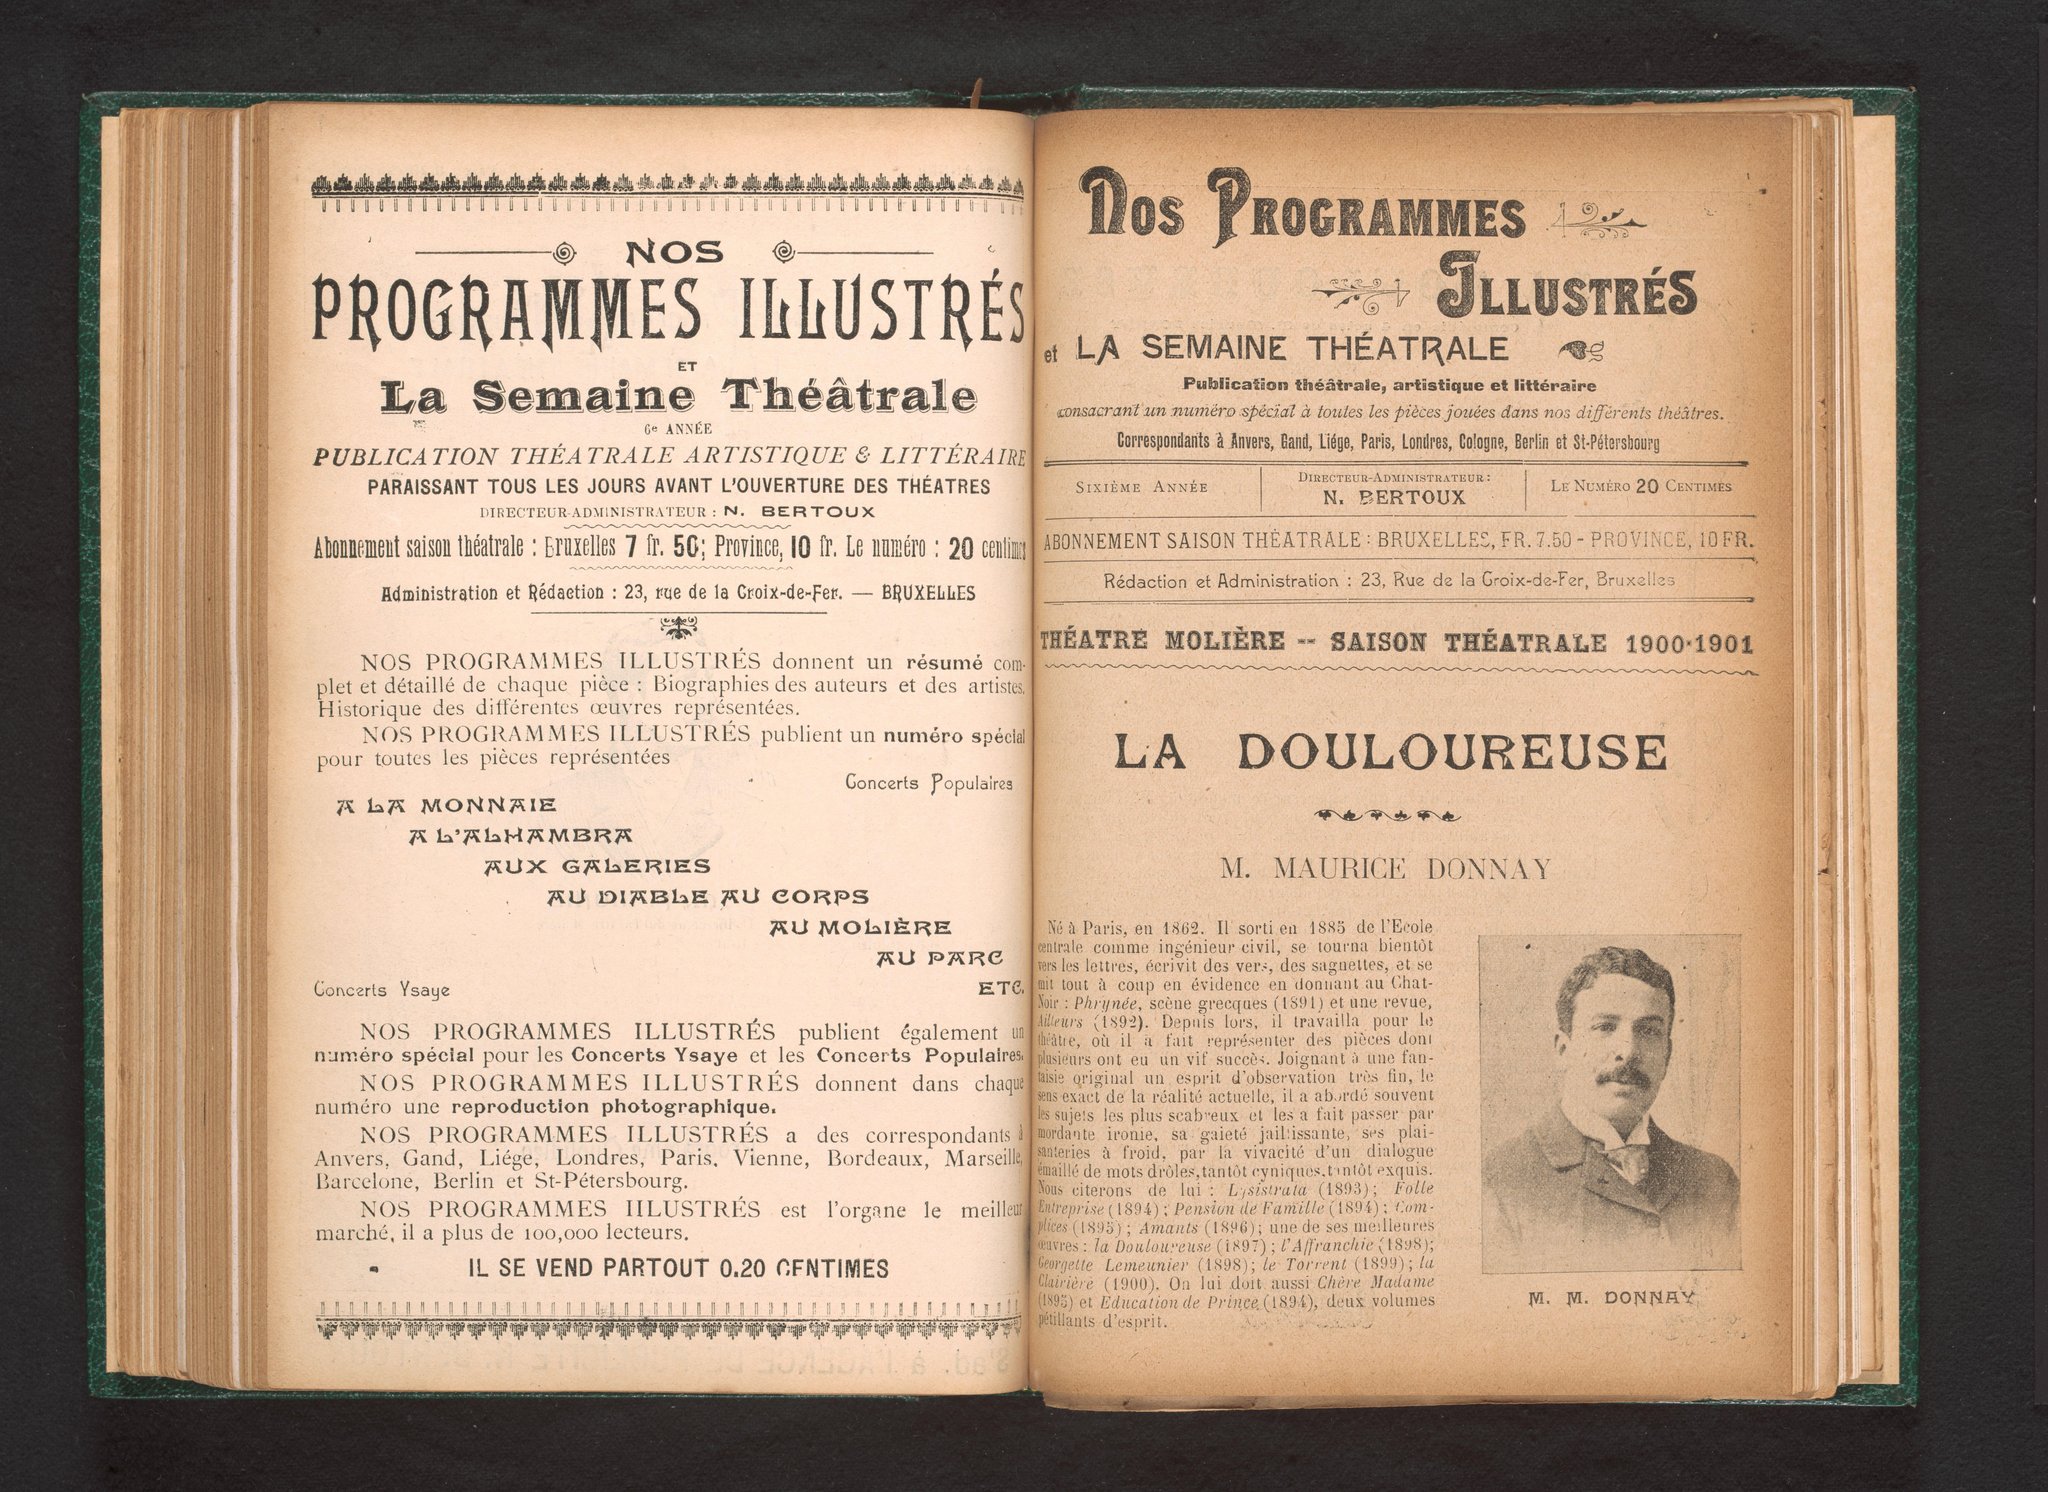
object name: page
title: M. M. Donnay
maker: Anonymous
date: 1895-1900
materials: paper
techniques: autotype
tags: paris, adult woman, historical persons